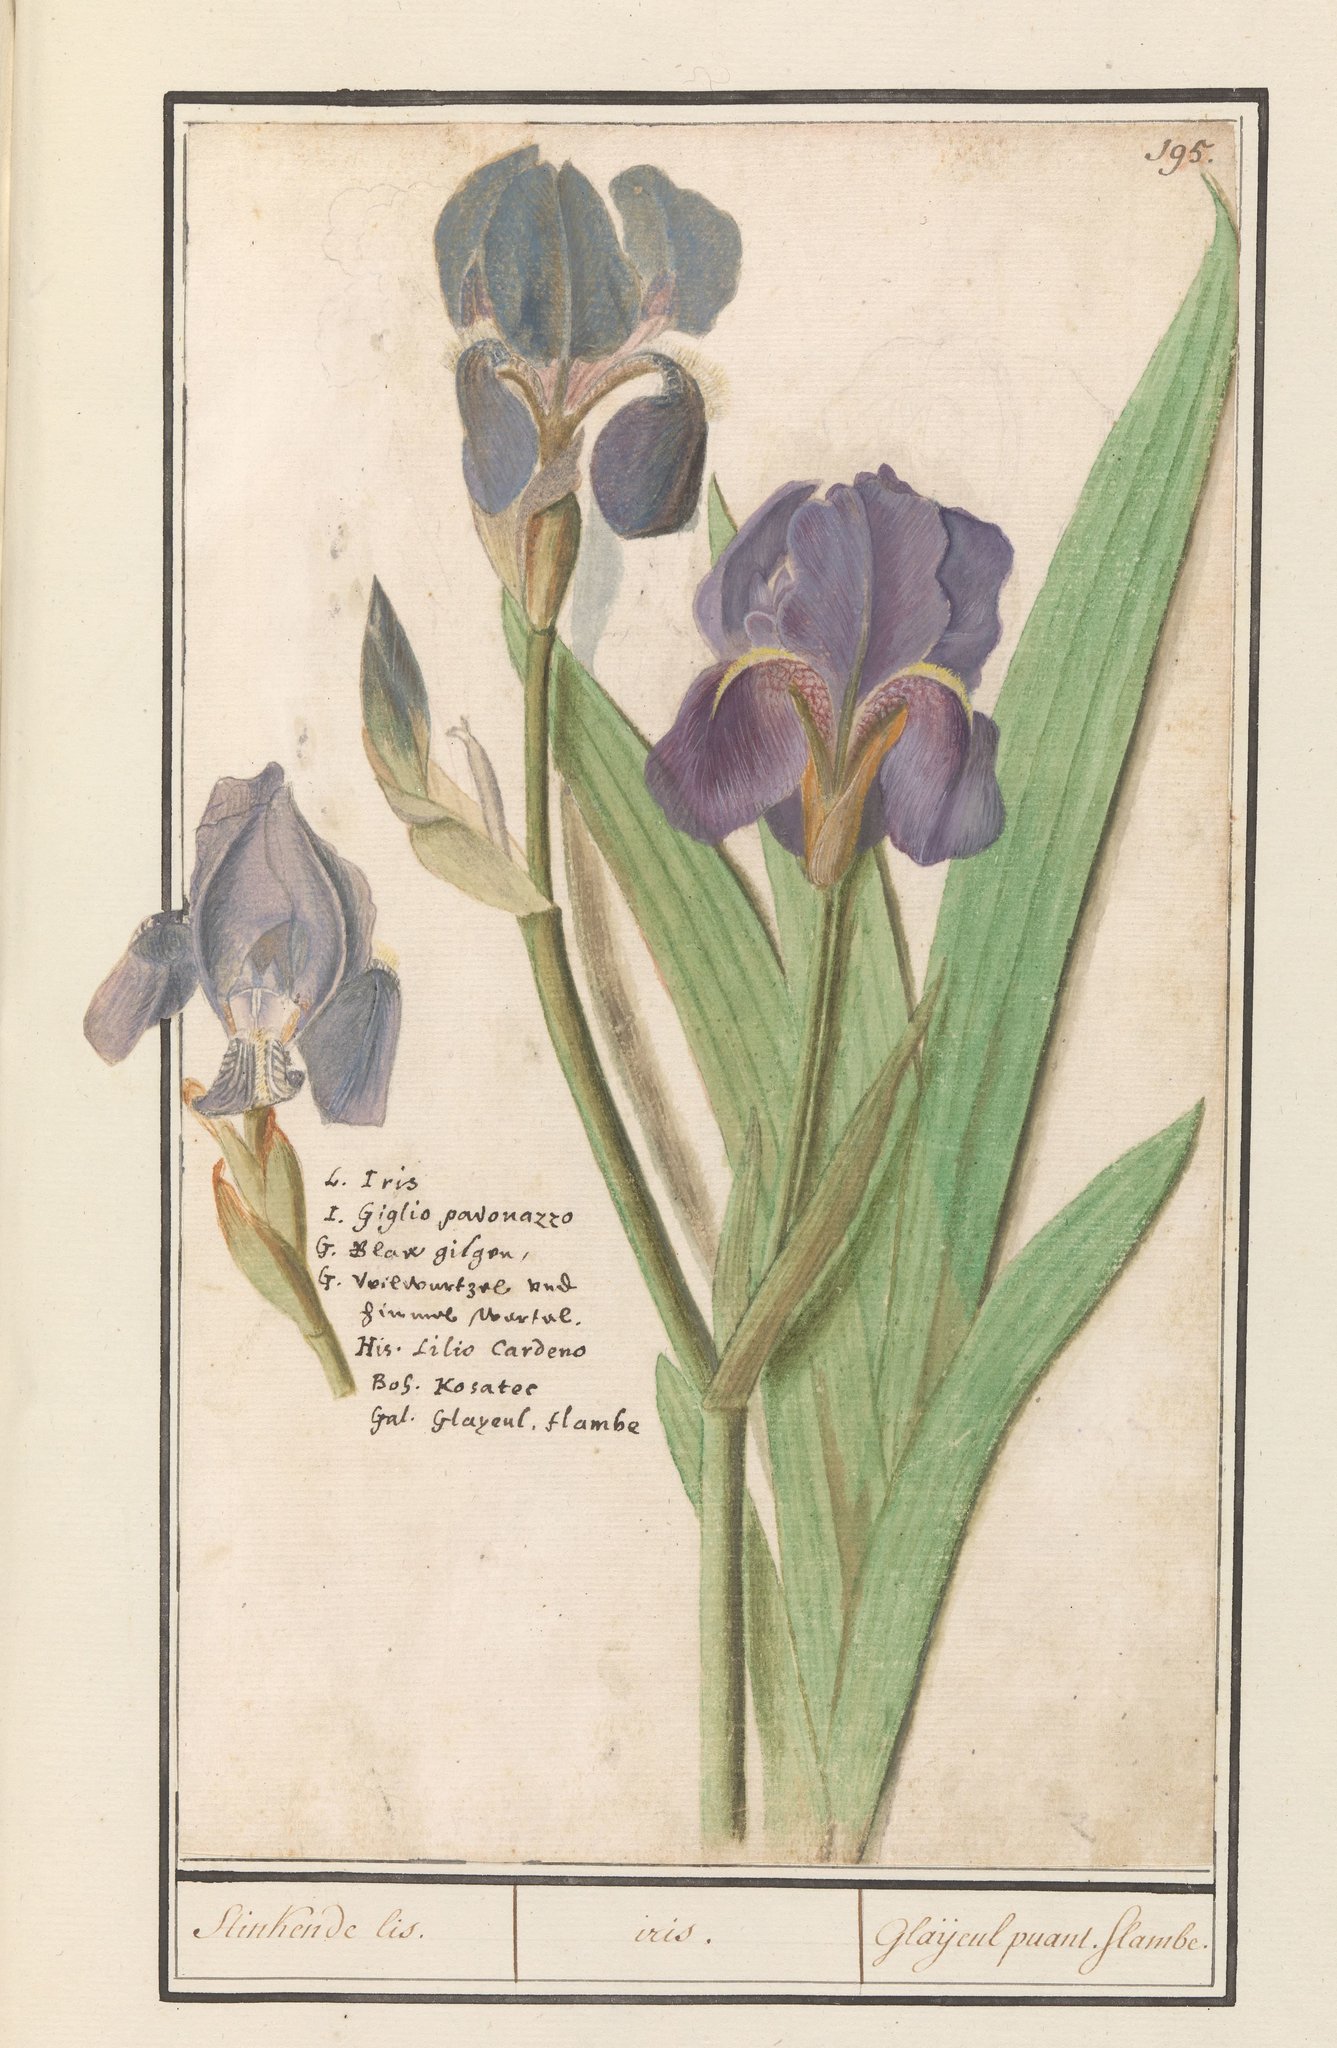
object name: drawing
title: Paarse iris (Iris germanica)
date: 1596-1610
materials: chalk, paint, ink, paper, watercolor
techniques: brush, pen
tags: flowers: iris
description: Paarse iris. Genummerd rechtsboven: 195. Linkonder de naam in zeven talen. Onderdeel van het tweede album met tekeningen van bloemen en planten. Negende van twaalf albums met tekeningen van dieren, vogels en planten bekend rond 1600, gemaakt in opdracht van keizer Rudolf II. Met toelichting in Nederlands, Latijn en Frans.